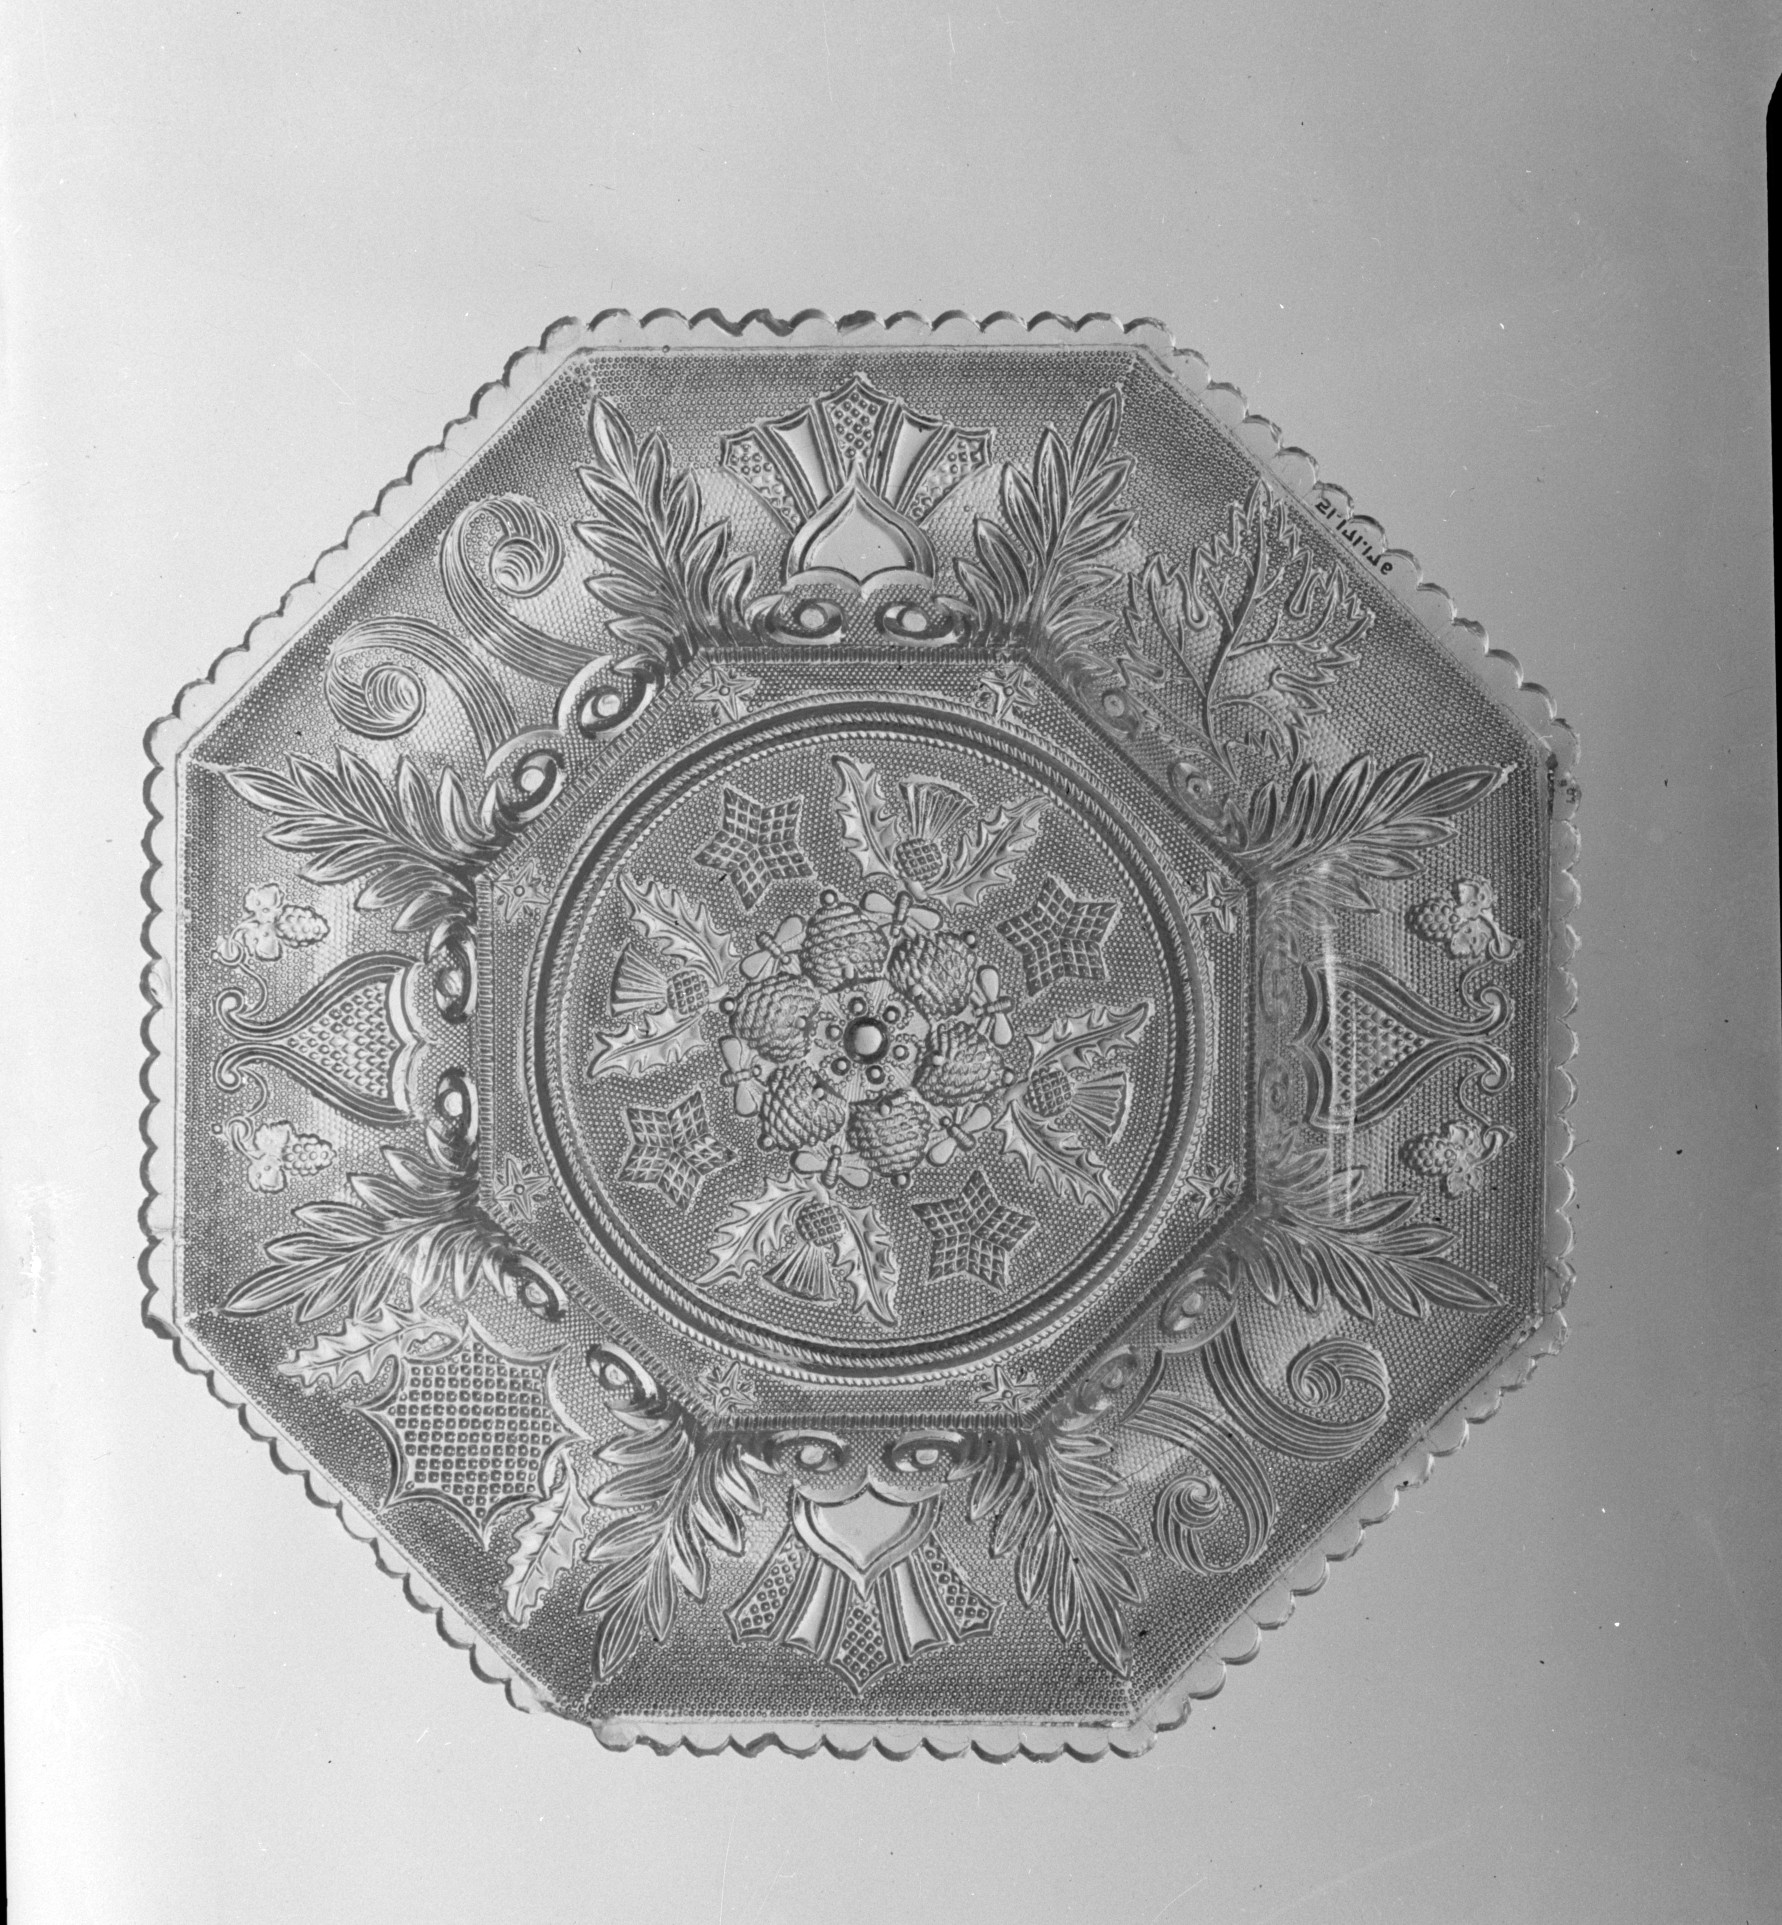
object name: dish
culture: american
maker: boston & sandwich glass company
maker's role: maker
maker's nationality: american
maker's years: 1825-1888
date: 1830-1850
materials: glass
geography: united states